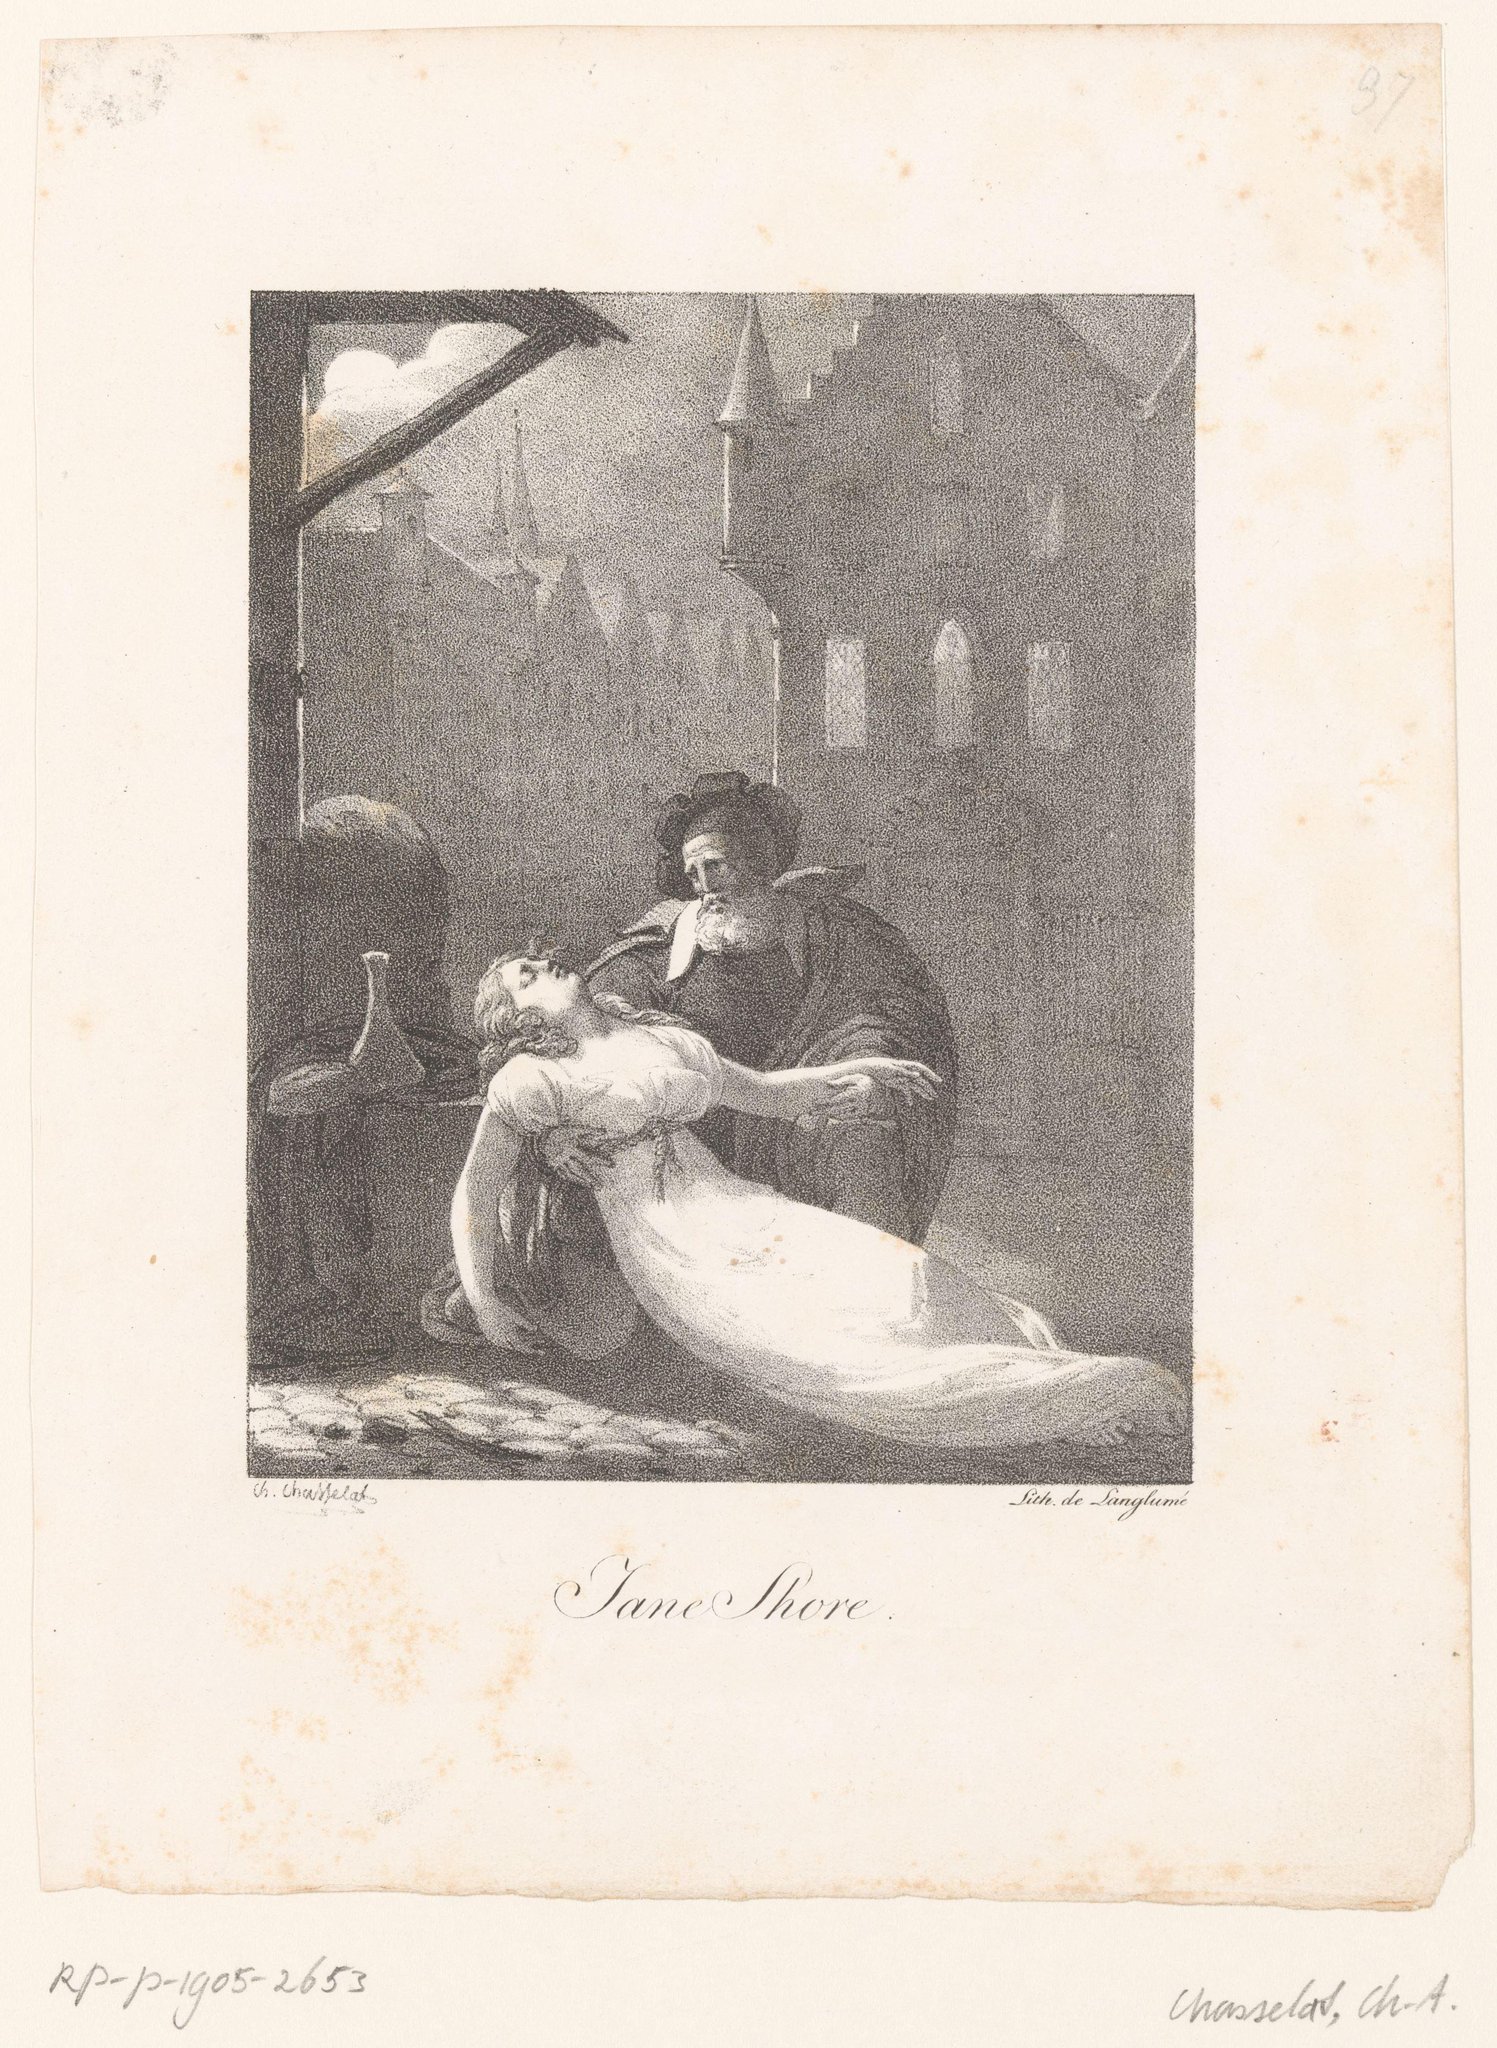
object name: print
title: Jane Shore sterft in de armen van Matthew Shore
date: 1820-1833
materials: paper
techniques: lithograph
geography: paris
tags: historical persons, dying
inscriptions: collector's mark: Lugt 2228a